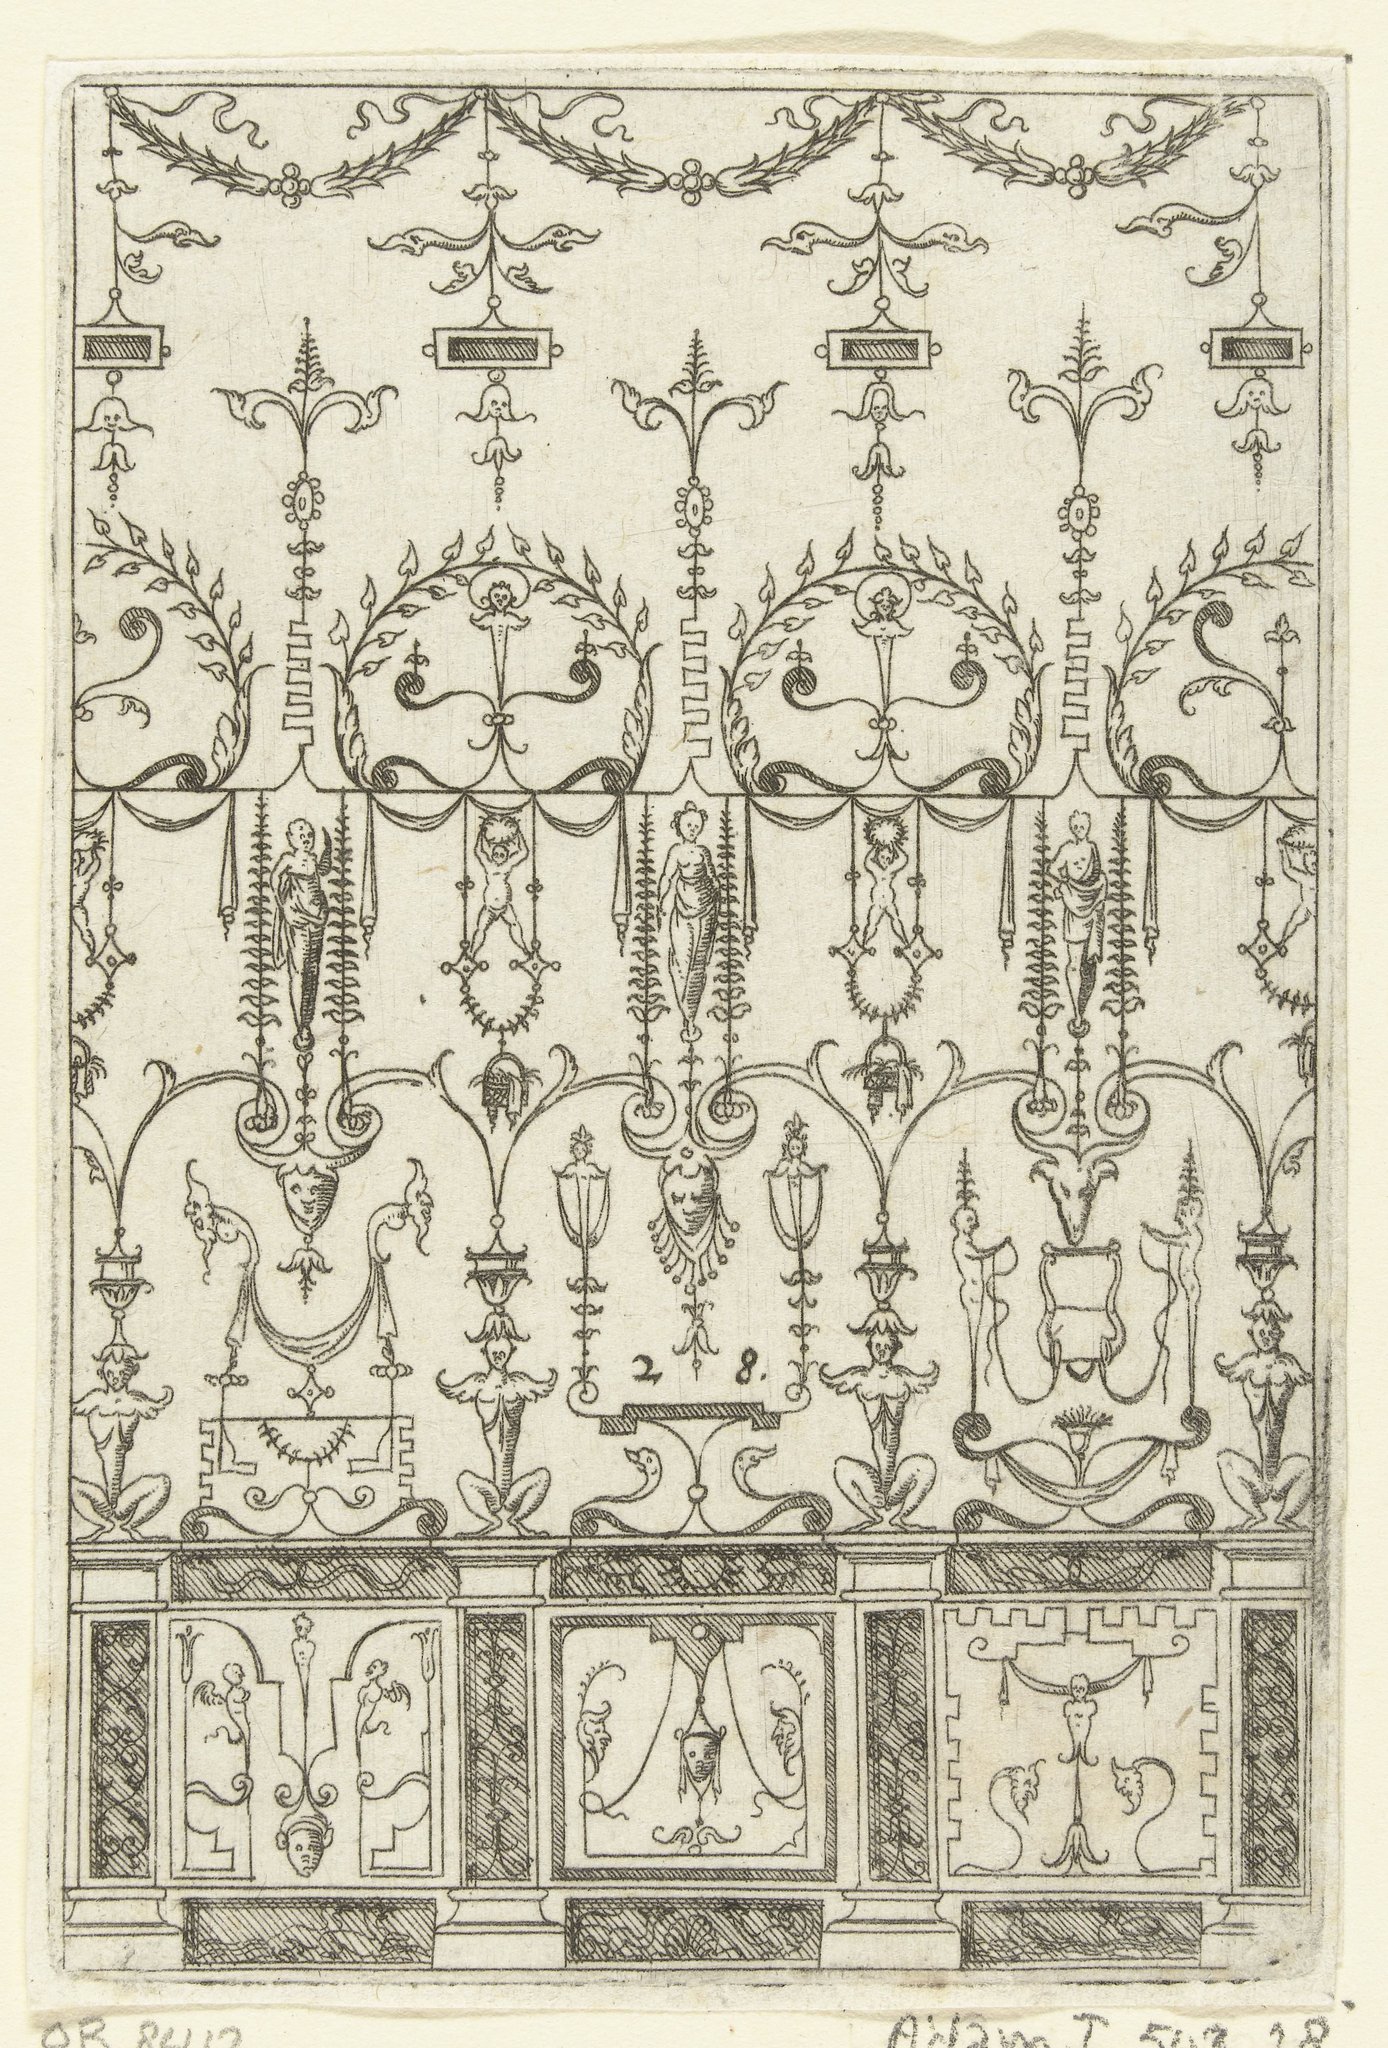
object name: ornament print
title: Op een fries, gedecoreerd met drie vierkante velden met mascarons, zitten vier gehurkte saters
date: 1525-1594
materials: paper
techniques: etching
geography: netherlands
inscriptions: collector's mark: Lugt 240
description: Kopie naar prent van Jacques Androuet Ducerceau, ontleend aan een vlakdecoratie van Enea Vico. Blad uit serie met architectuurfantasieën en grotesken met fabelwezens, guirlandes, kandelabers en mascarons.